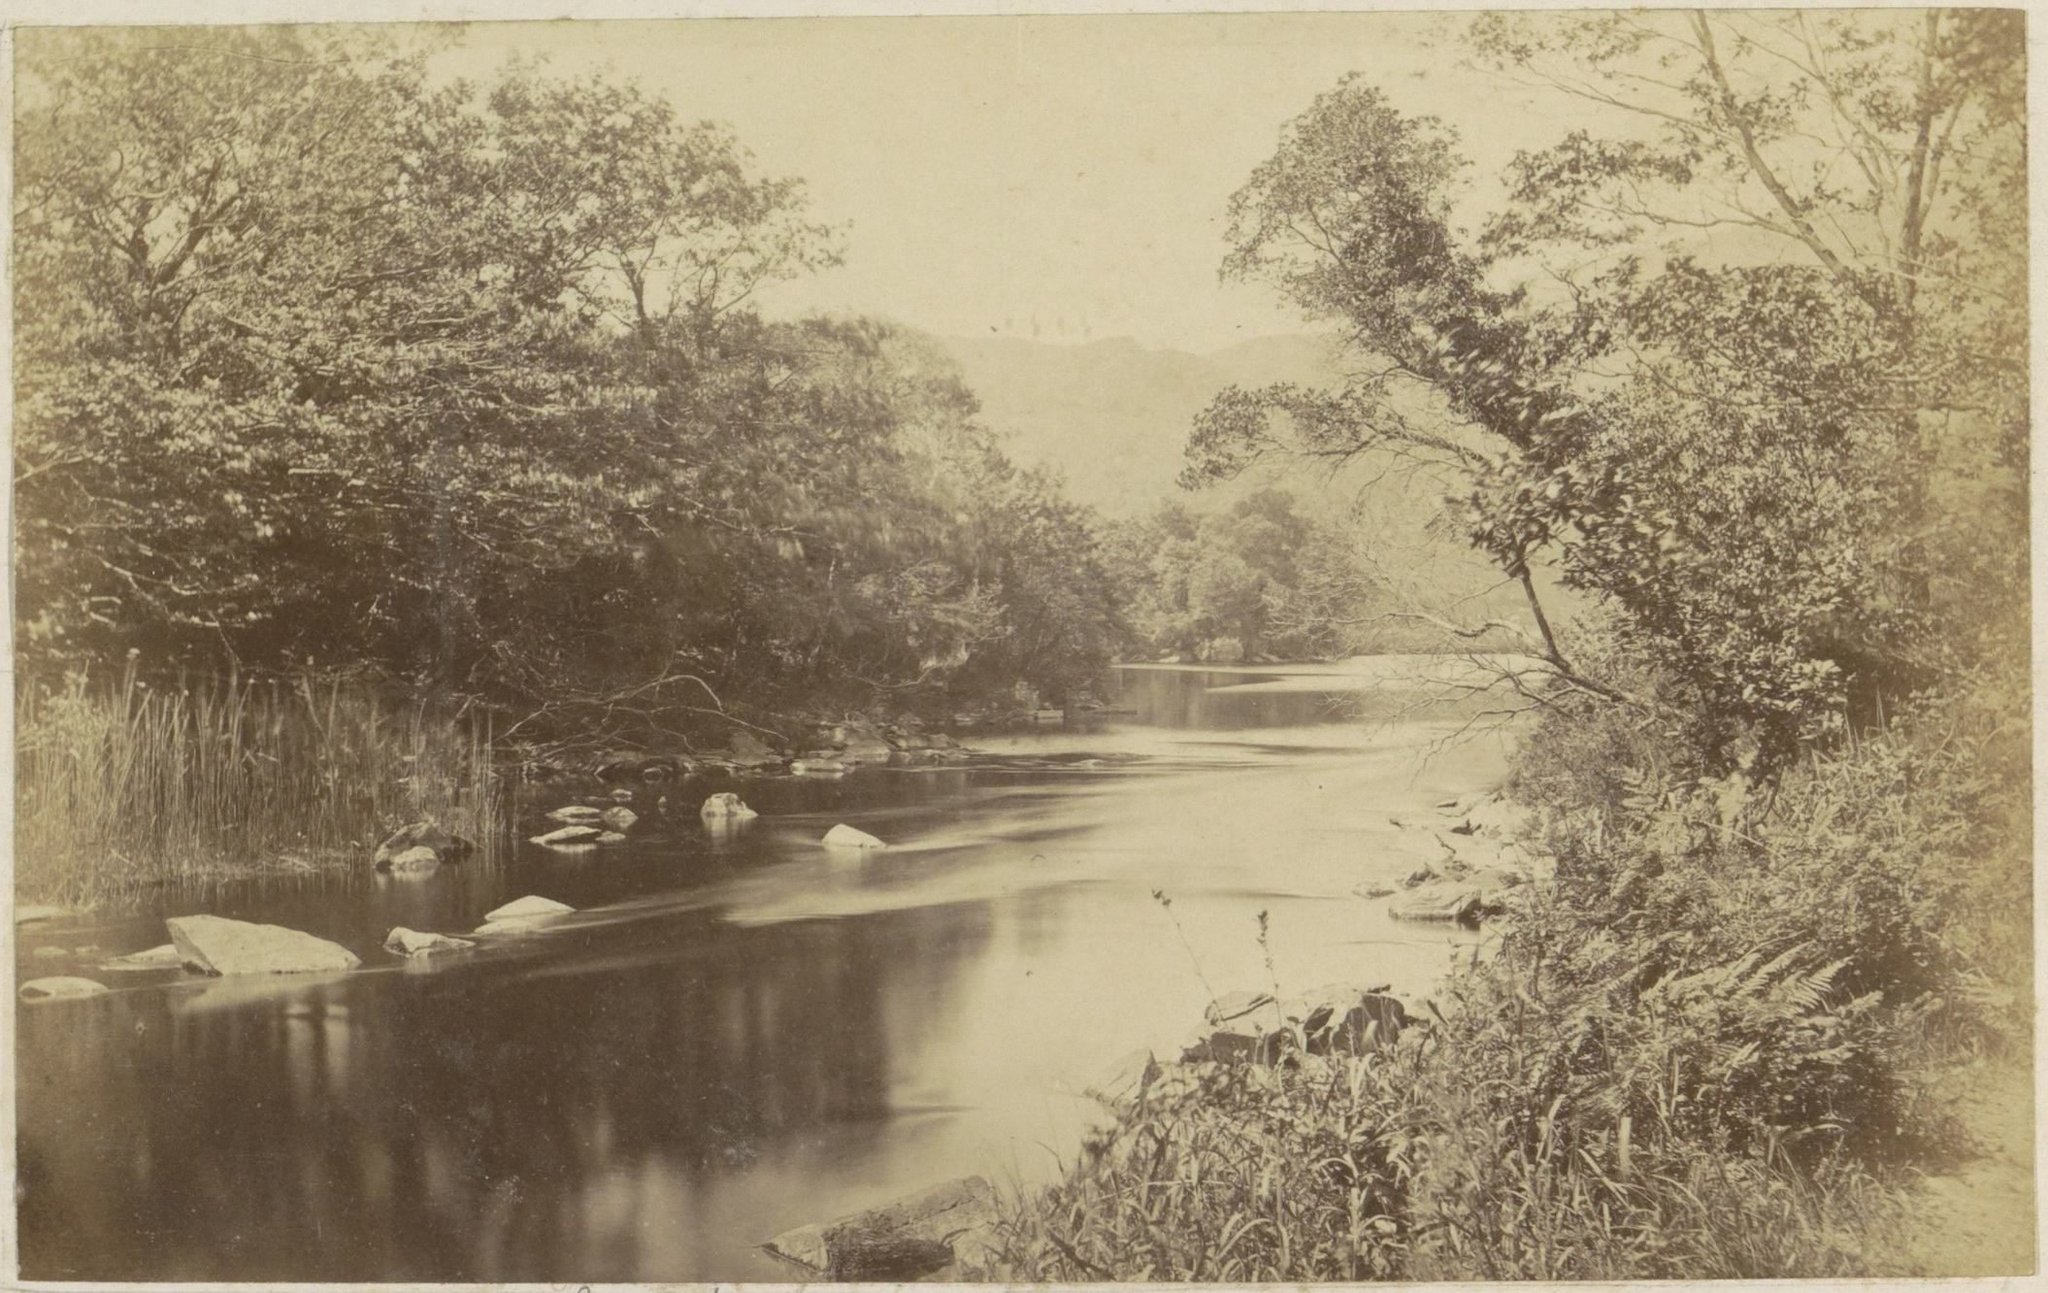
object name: photograph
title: Rivierlandschap, vermoedelijk in Engeland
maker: Anonymous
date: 1850-1870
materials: paper, photographic support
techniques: albumen print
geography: england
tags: landscapes with waters, waterscapes, seascapes (in the temperate zone) (+ landscape with figures, staffage), england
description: Onderdeel van Album met foto's van bezienswaardigheden en landschappen in Engeland en van kunst.